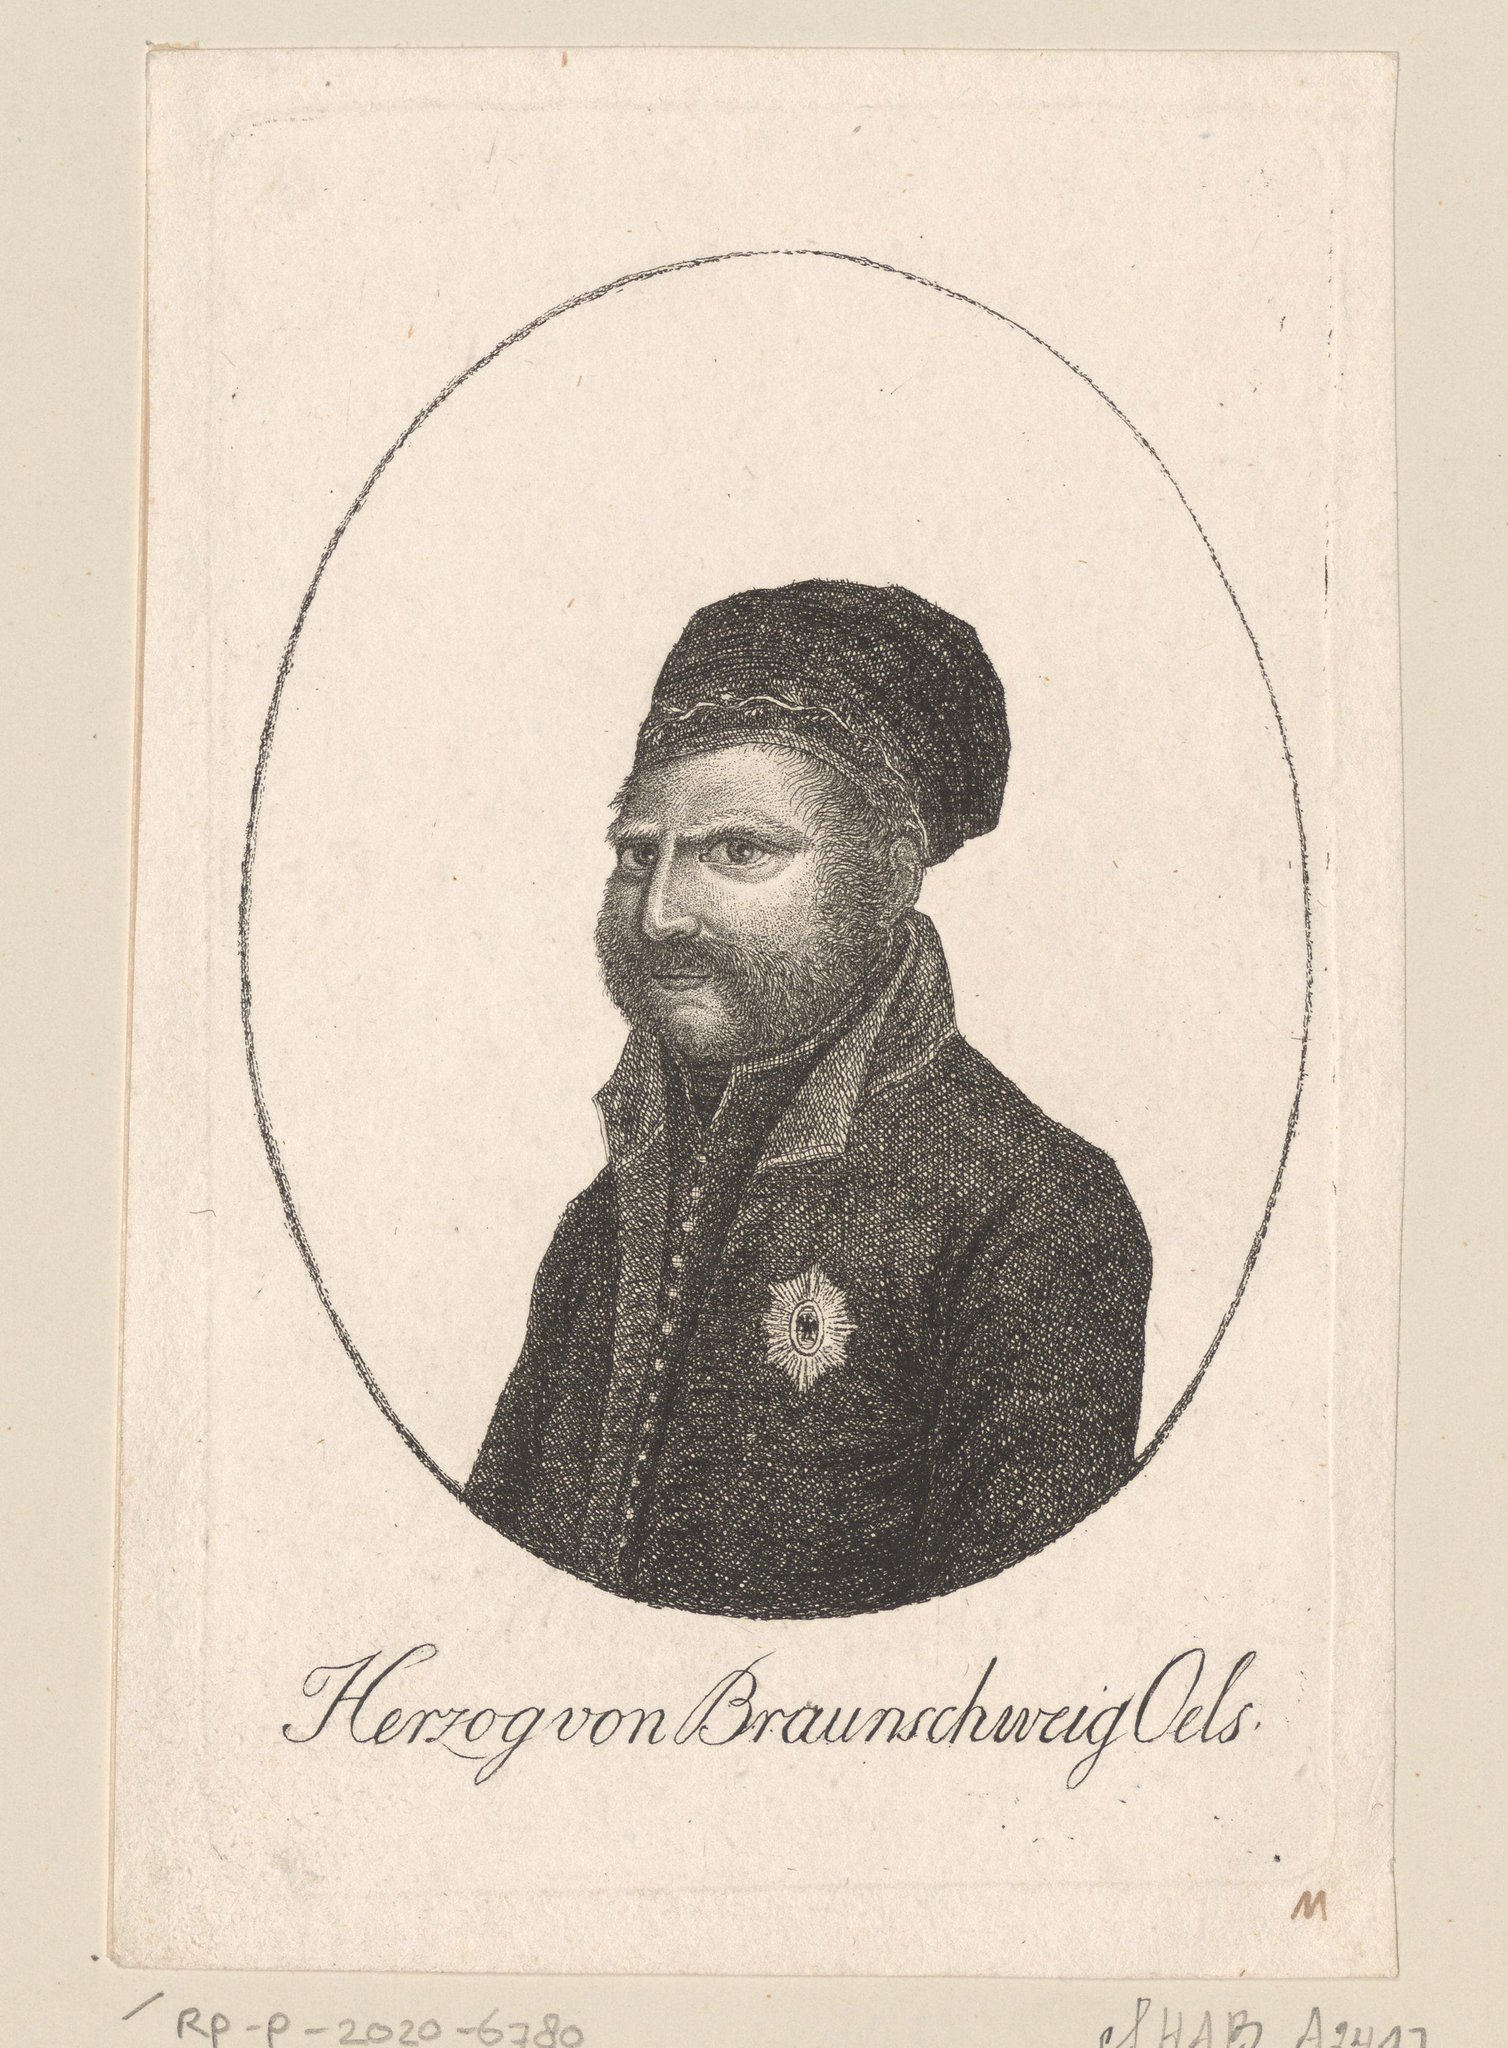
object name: print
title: Portret van Frederik Willem van Brunswijk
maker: Anonymous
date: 1809-1850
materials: paper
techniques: etching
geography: germany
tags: historical persons, head-gear: cap